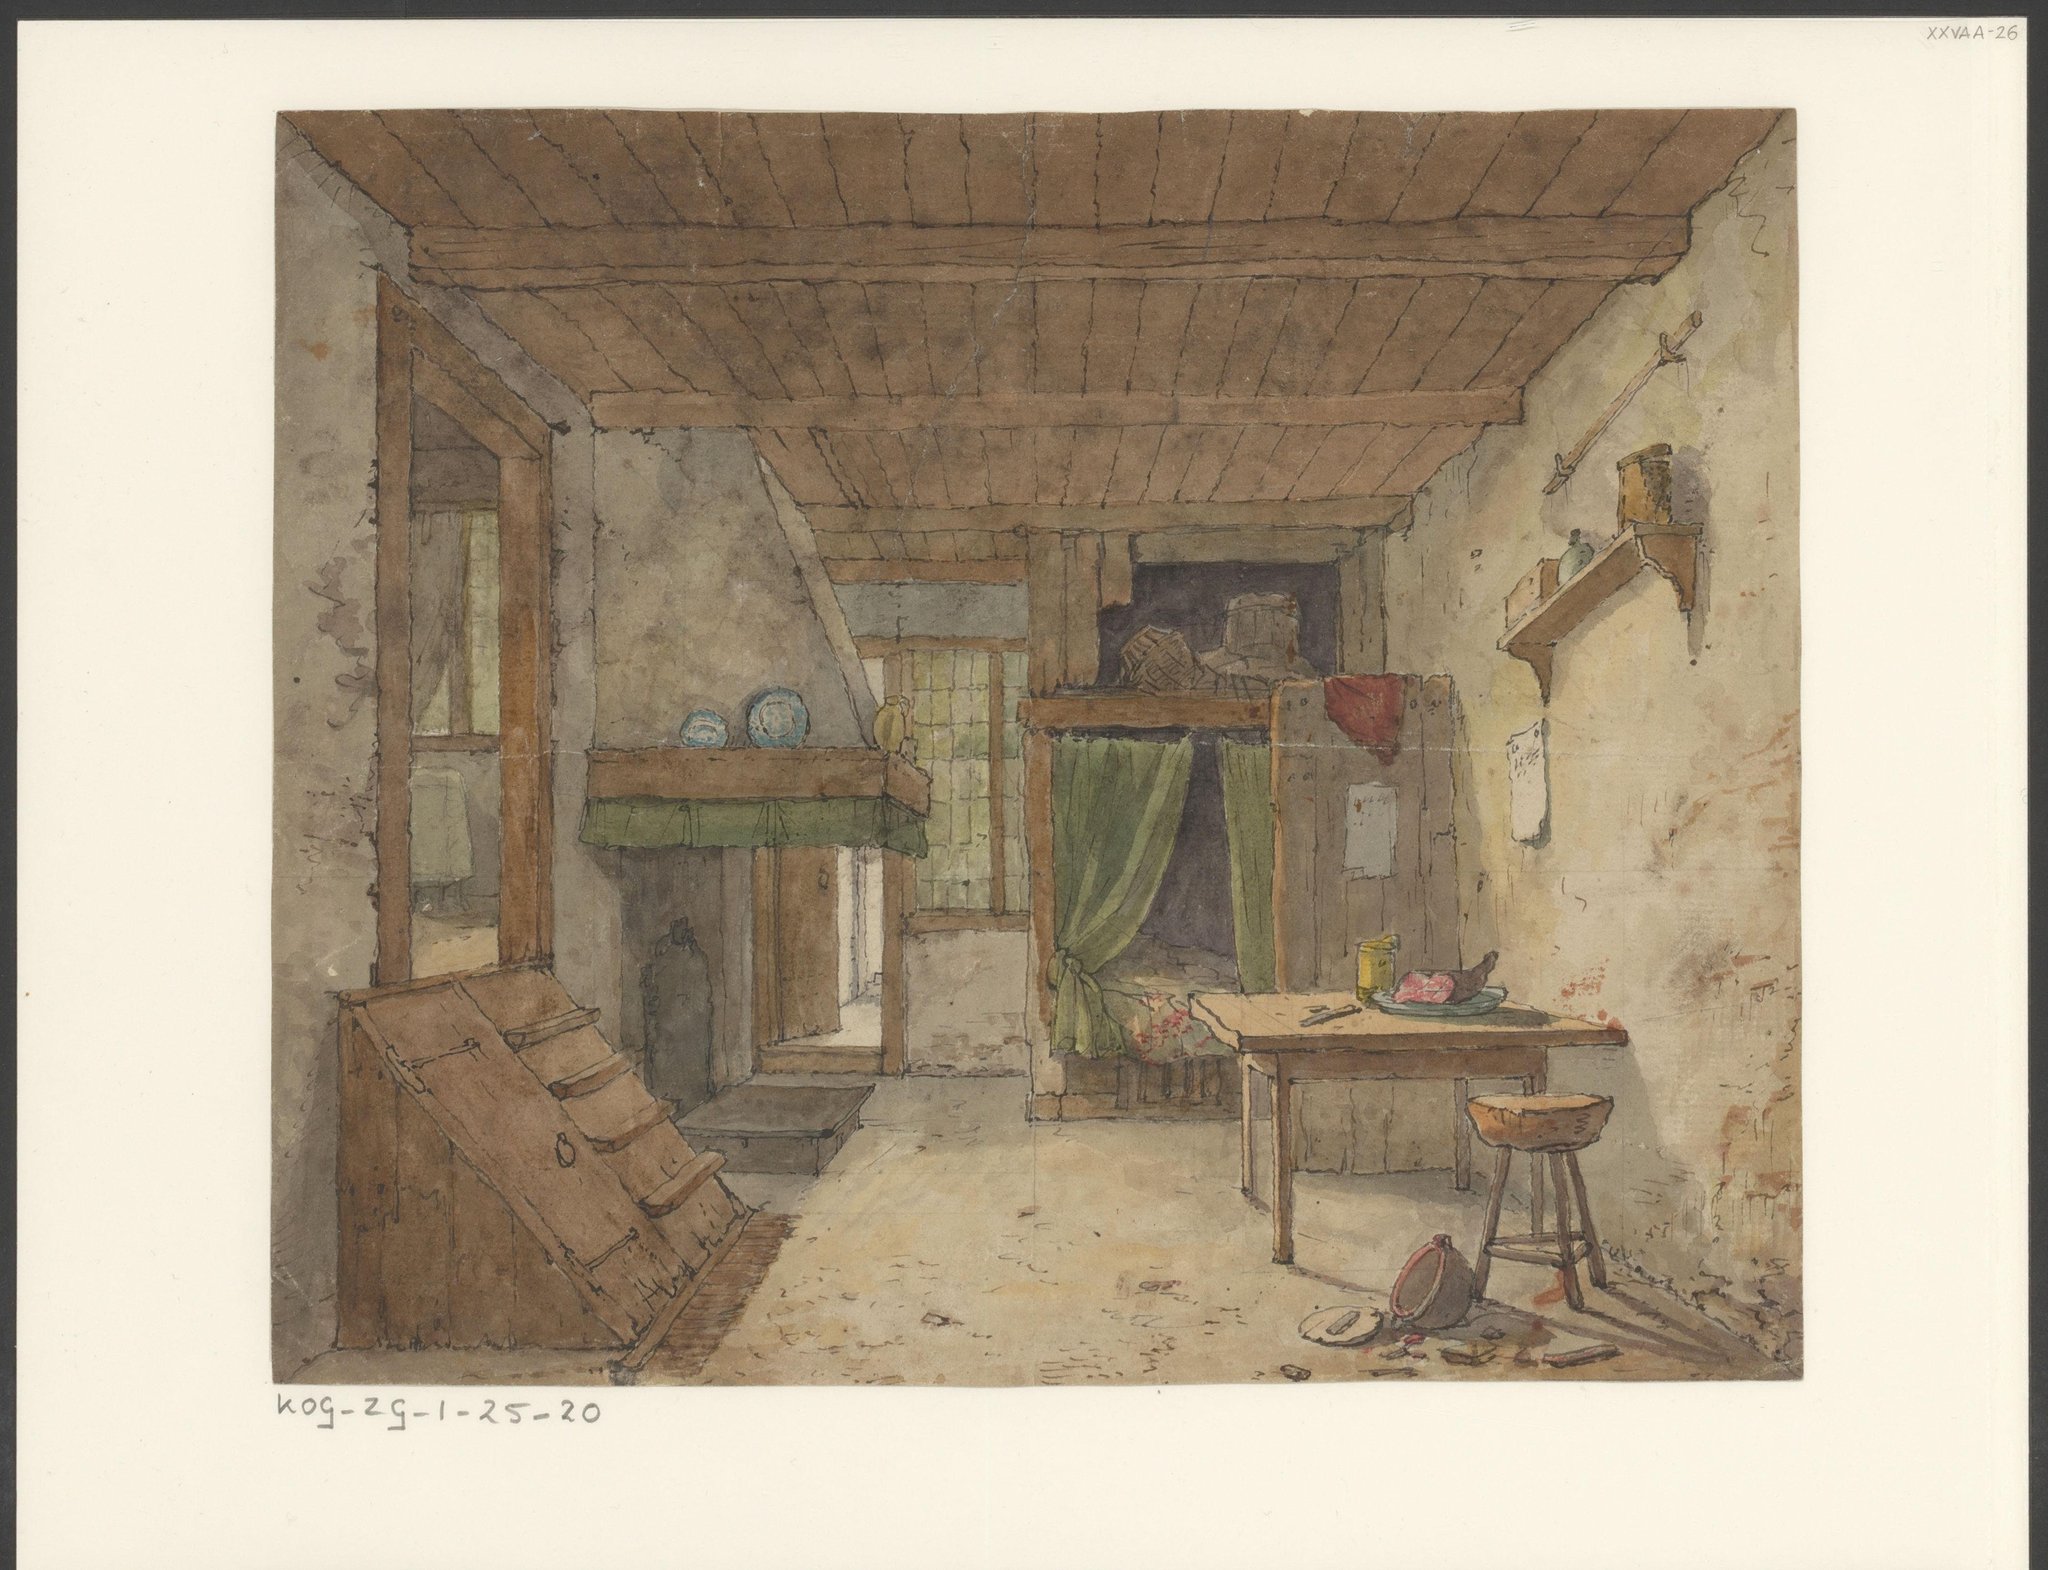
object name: drawing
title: Boerenvertrek met bedstee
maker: Anonymous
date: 1800-1899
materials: ink, paper, watercolor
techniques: brush, pen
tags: urban housing, built-in bedstead (dutch: 'bedstee')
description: Onderwerpsrubrieken binnen de Atlas Zeden en Gewoonten: Zeden en Gewoonten in Engeren Zin, De Woning, Binnenhuizen, Kamerbetimmering.